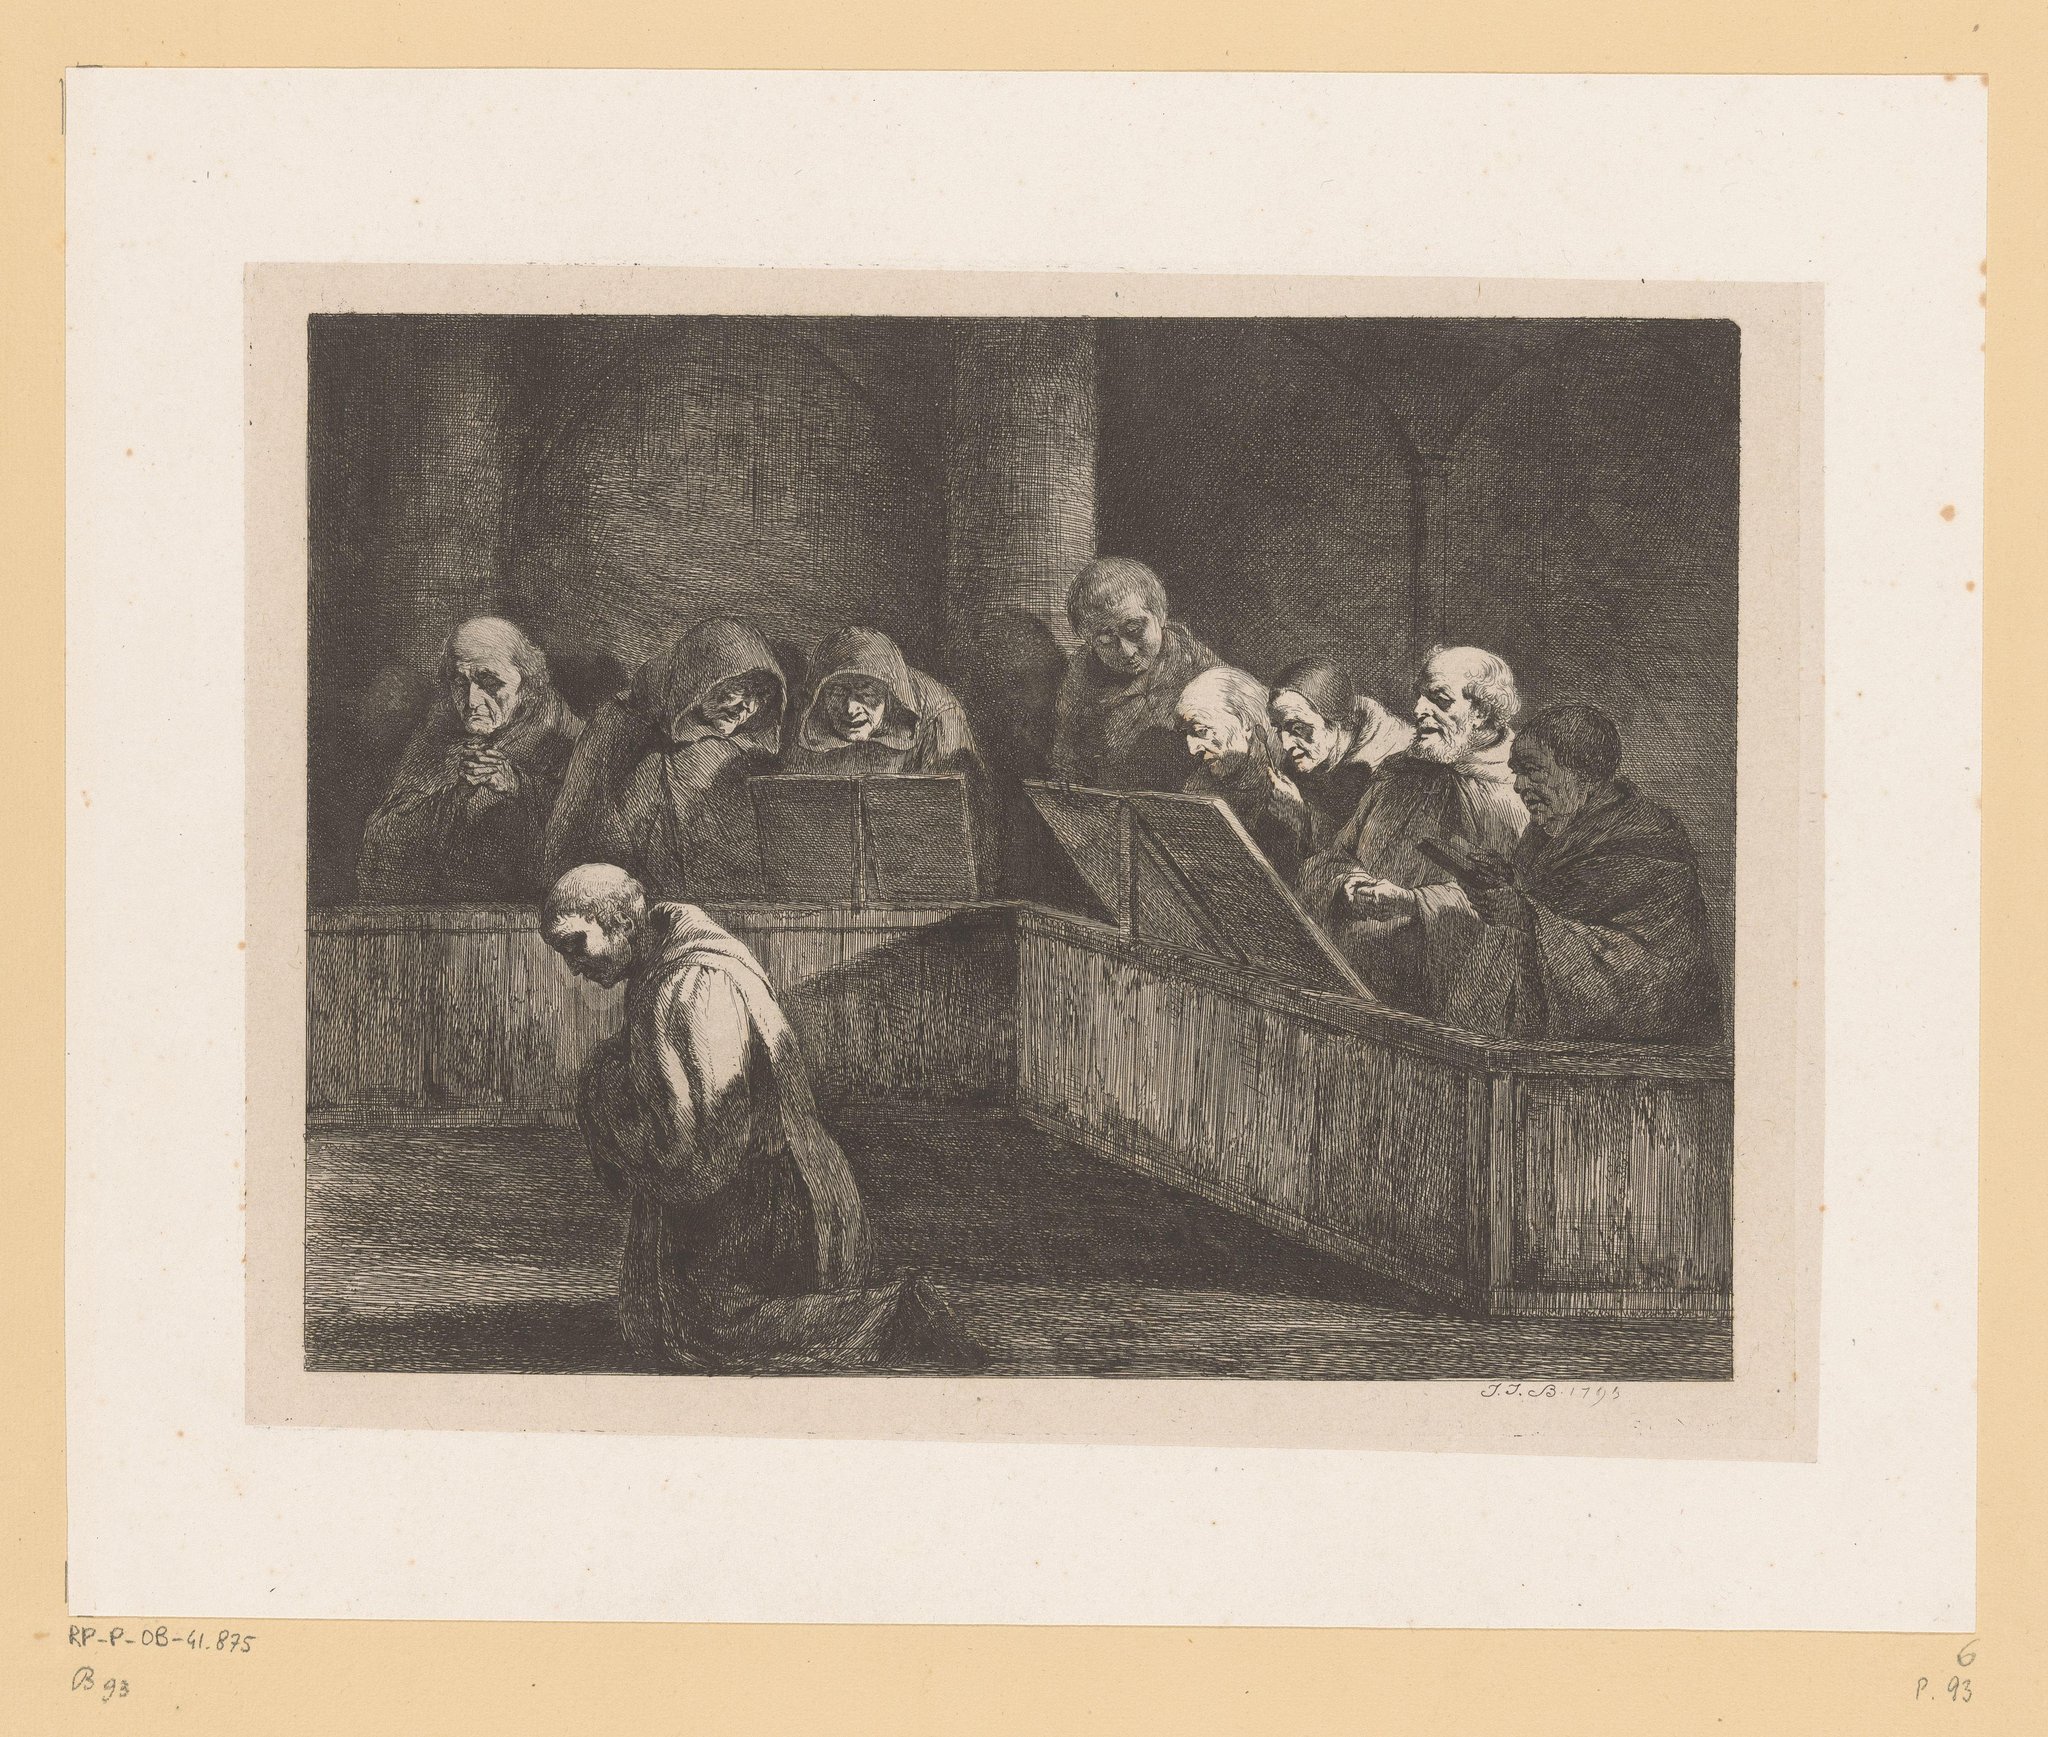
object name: print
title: Monniken de mis zingend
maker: jean jacques de boissieu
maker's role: draughtsman, print maker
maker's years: 1736-1810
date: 1795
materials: paper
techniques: etching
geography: france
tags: singing of psalms, hymns, etc., singing (in church), monk(s), friar(s)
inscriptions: collector's mark: Lugt 12